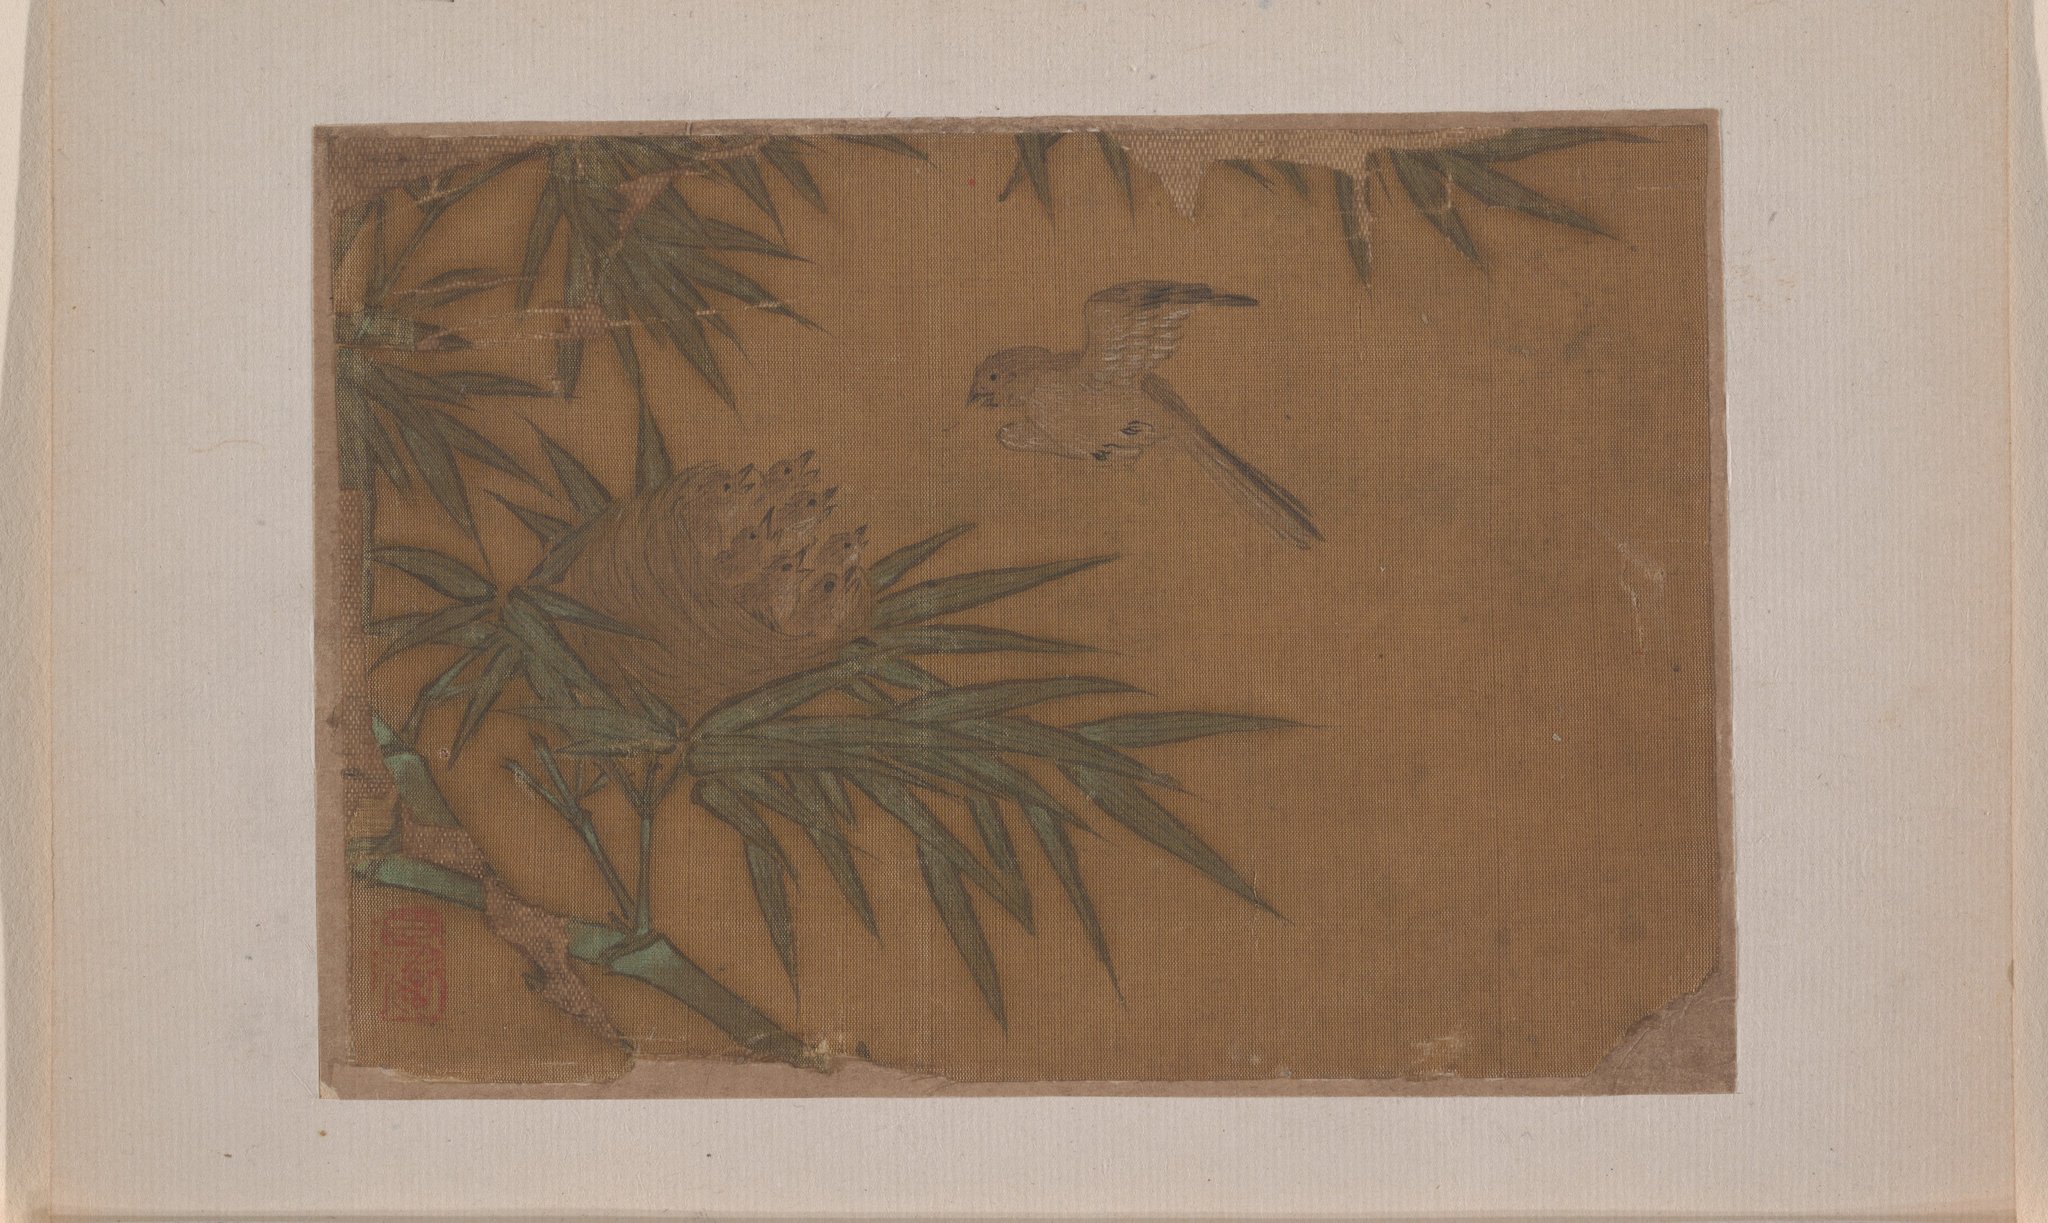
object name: album leaf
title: Seven Birds in Bamboo Tree Nest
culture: chinese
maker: unidentified artist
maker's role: artist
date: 1368-1644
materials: ink, silk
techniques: painting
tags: birds,bamboo